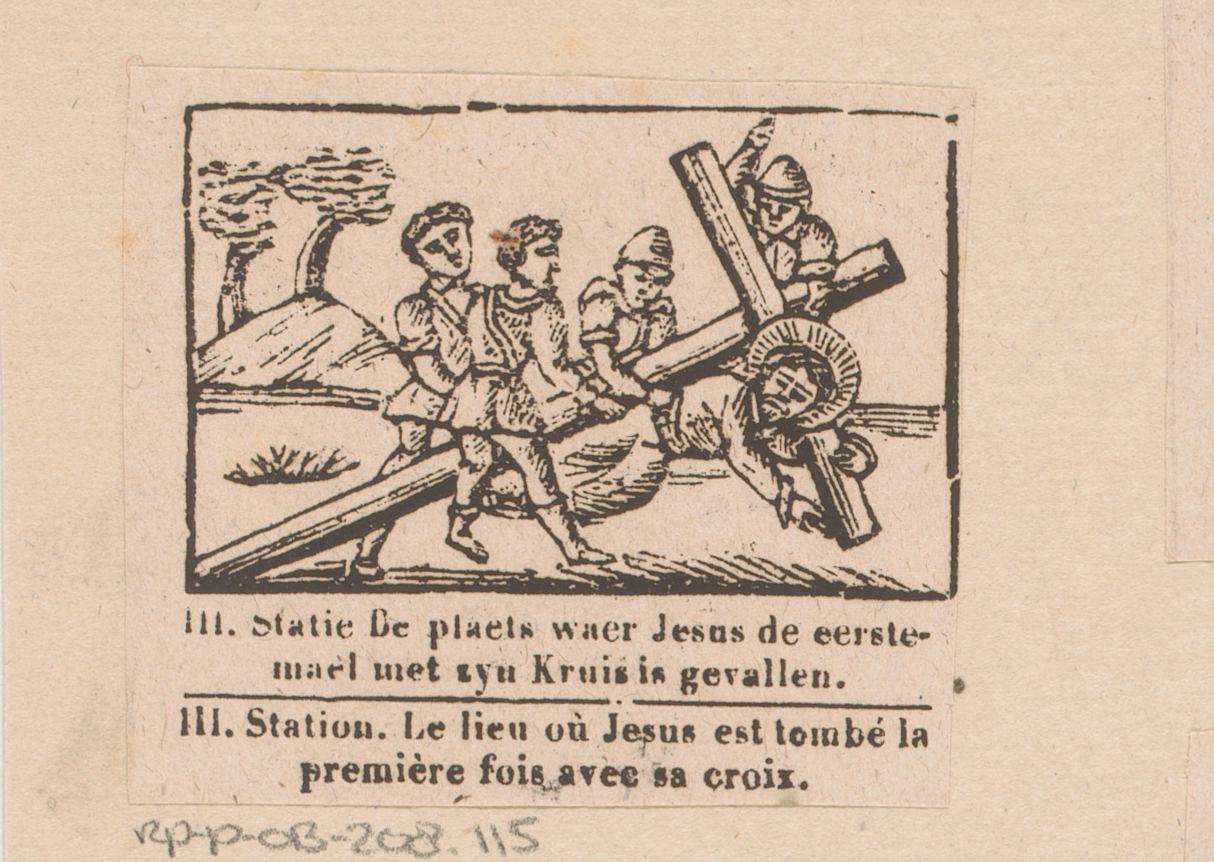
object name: print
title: Kruiswegstaties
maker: Anonymous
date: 1600-1699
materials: paper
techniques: letterpress printing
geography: netherlands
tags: first fall ~ christ carrying the cross, the 14 franciscan stations of the cross (3)